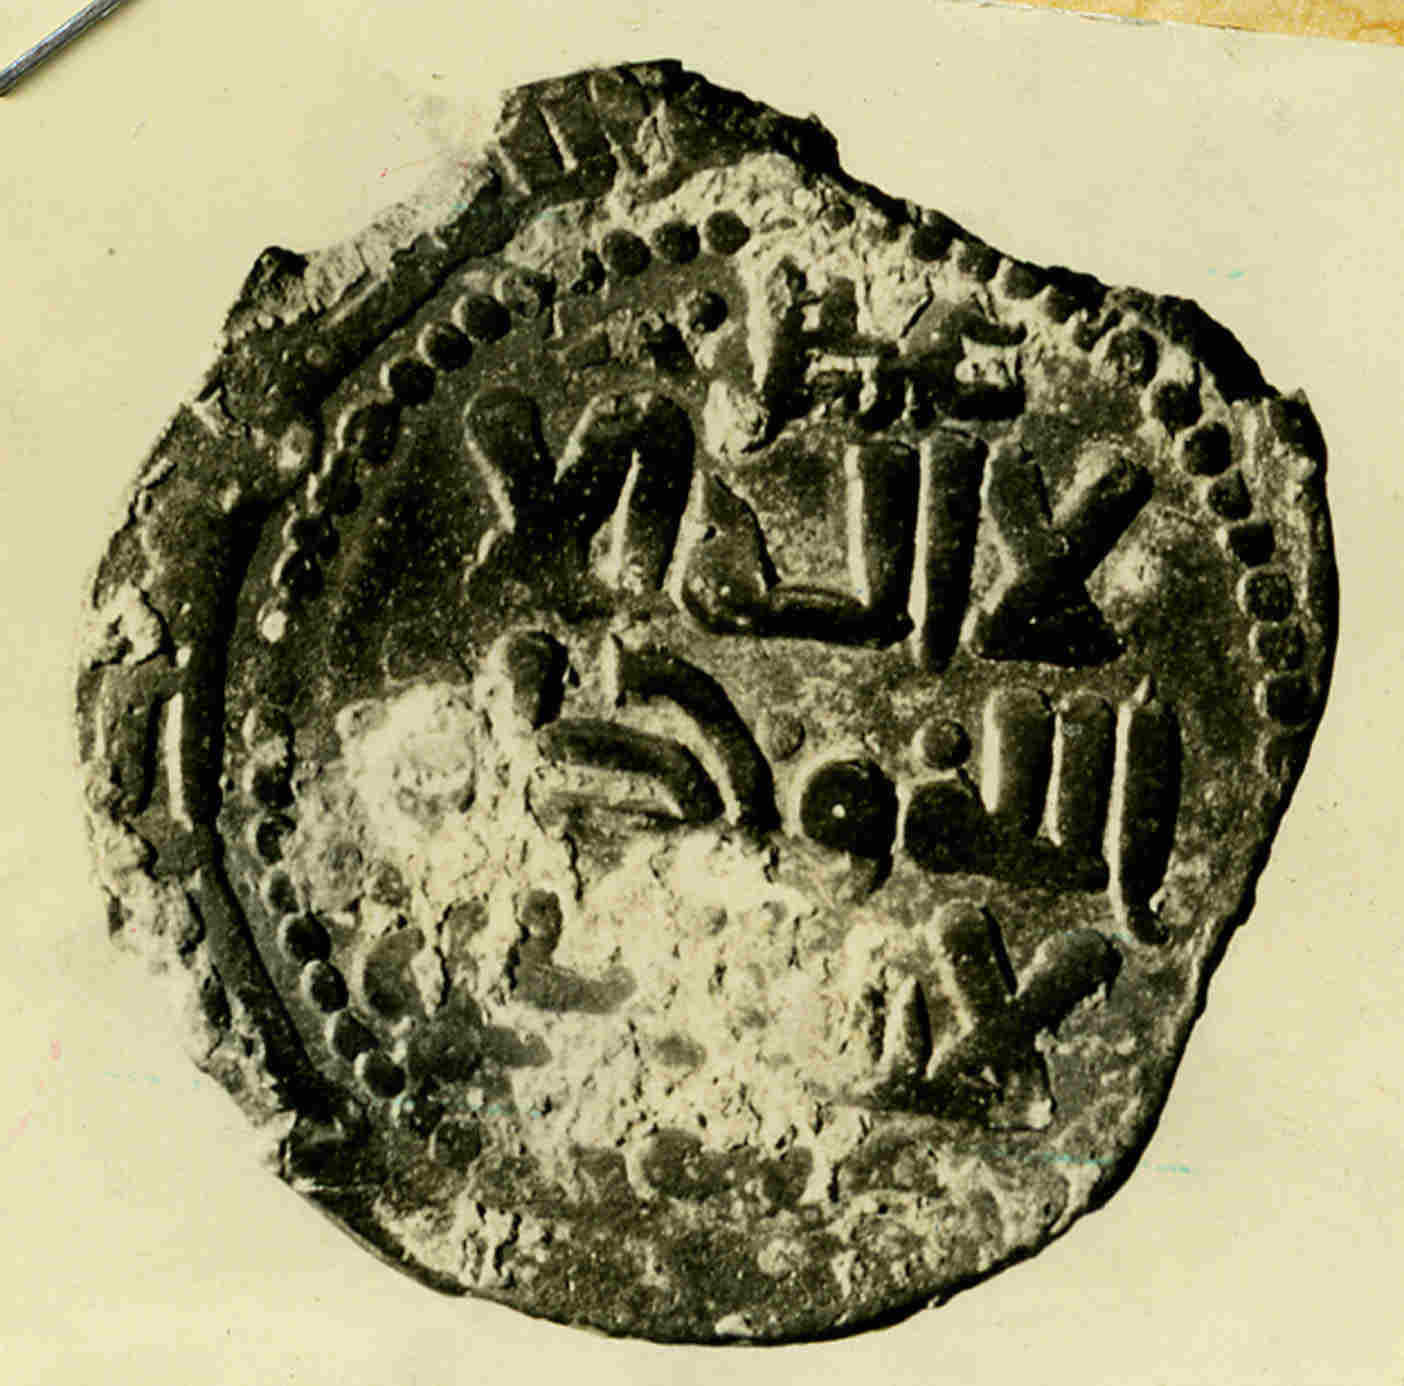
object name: coin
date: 1030-1074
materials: copper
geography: iran